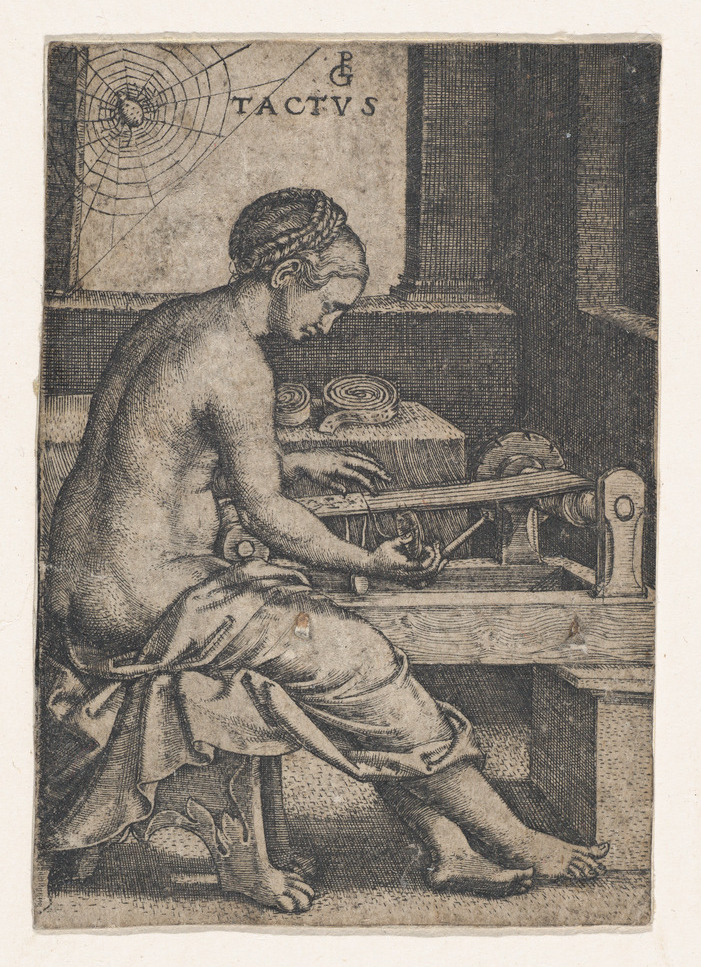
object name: print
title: Touch (Tactus), from "The Five Senses"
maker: georg pencz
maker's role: artist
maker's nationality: german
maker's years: 1500-1550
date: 1539-1549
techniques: engraving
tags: female nudes,spiders,looms